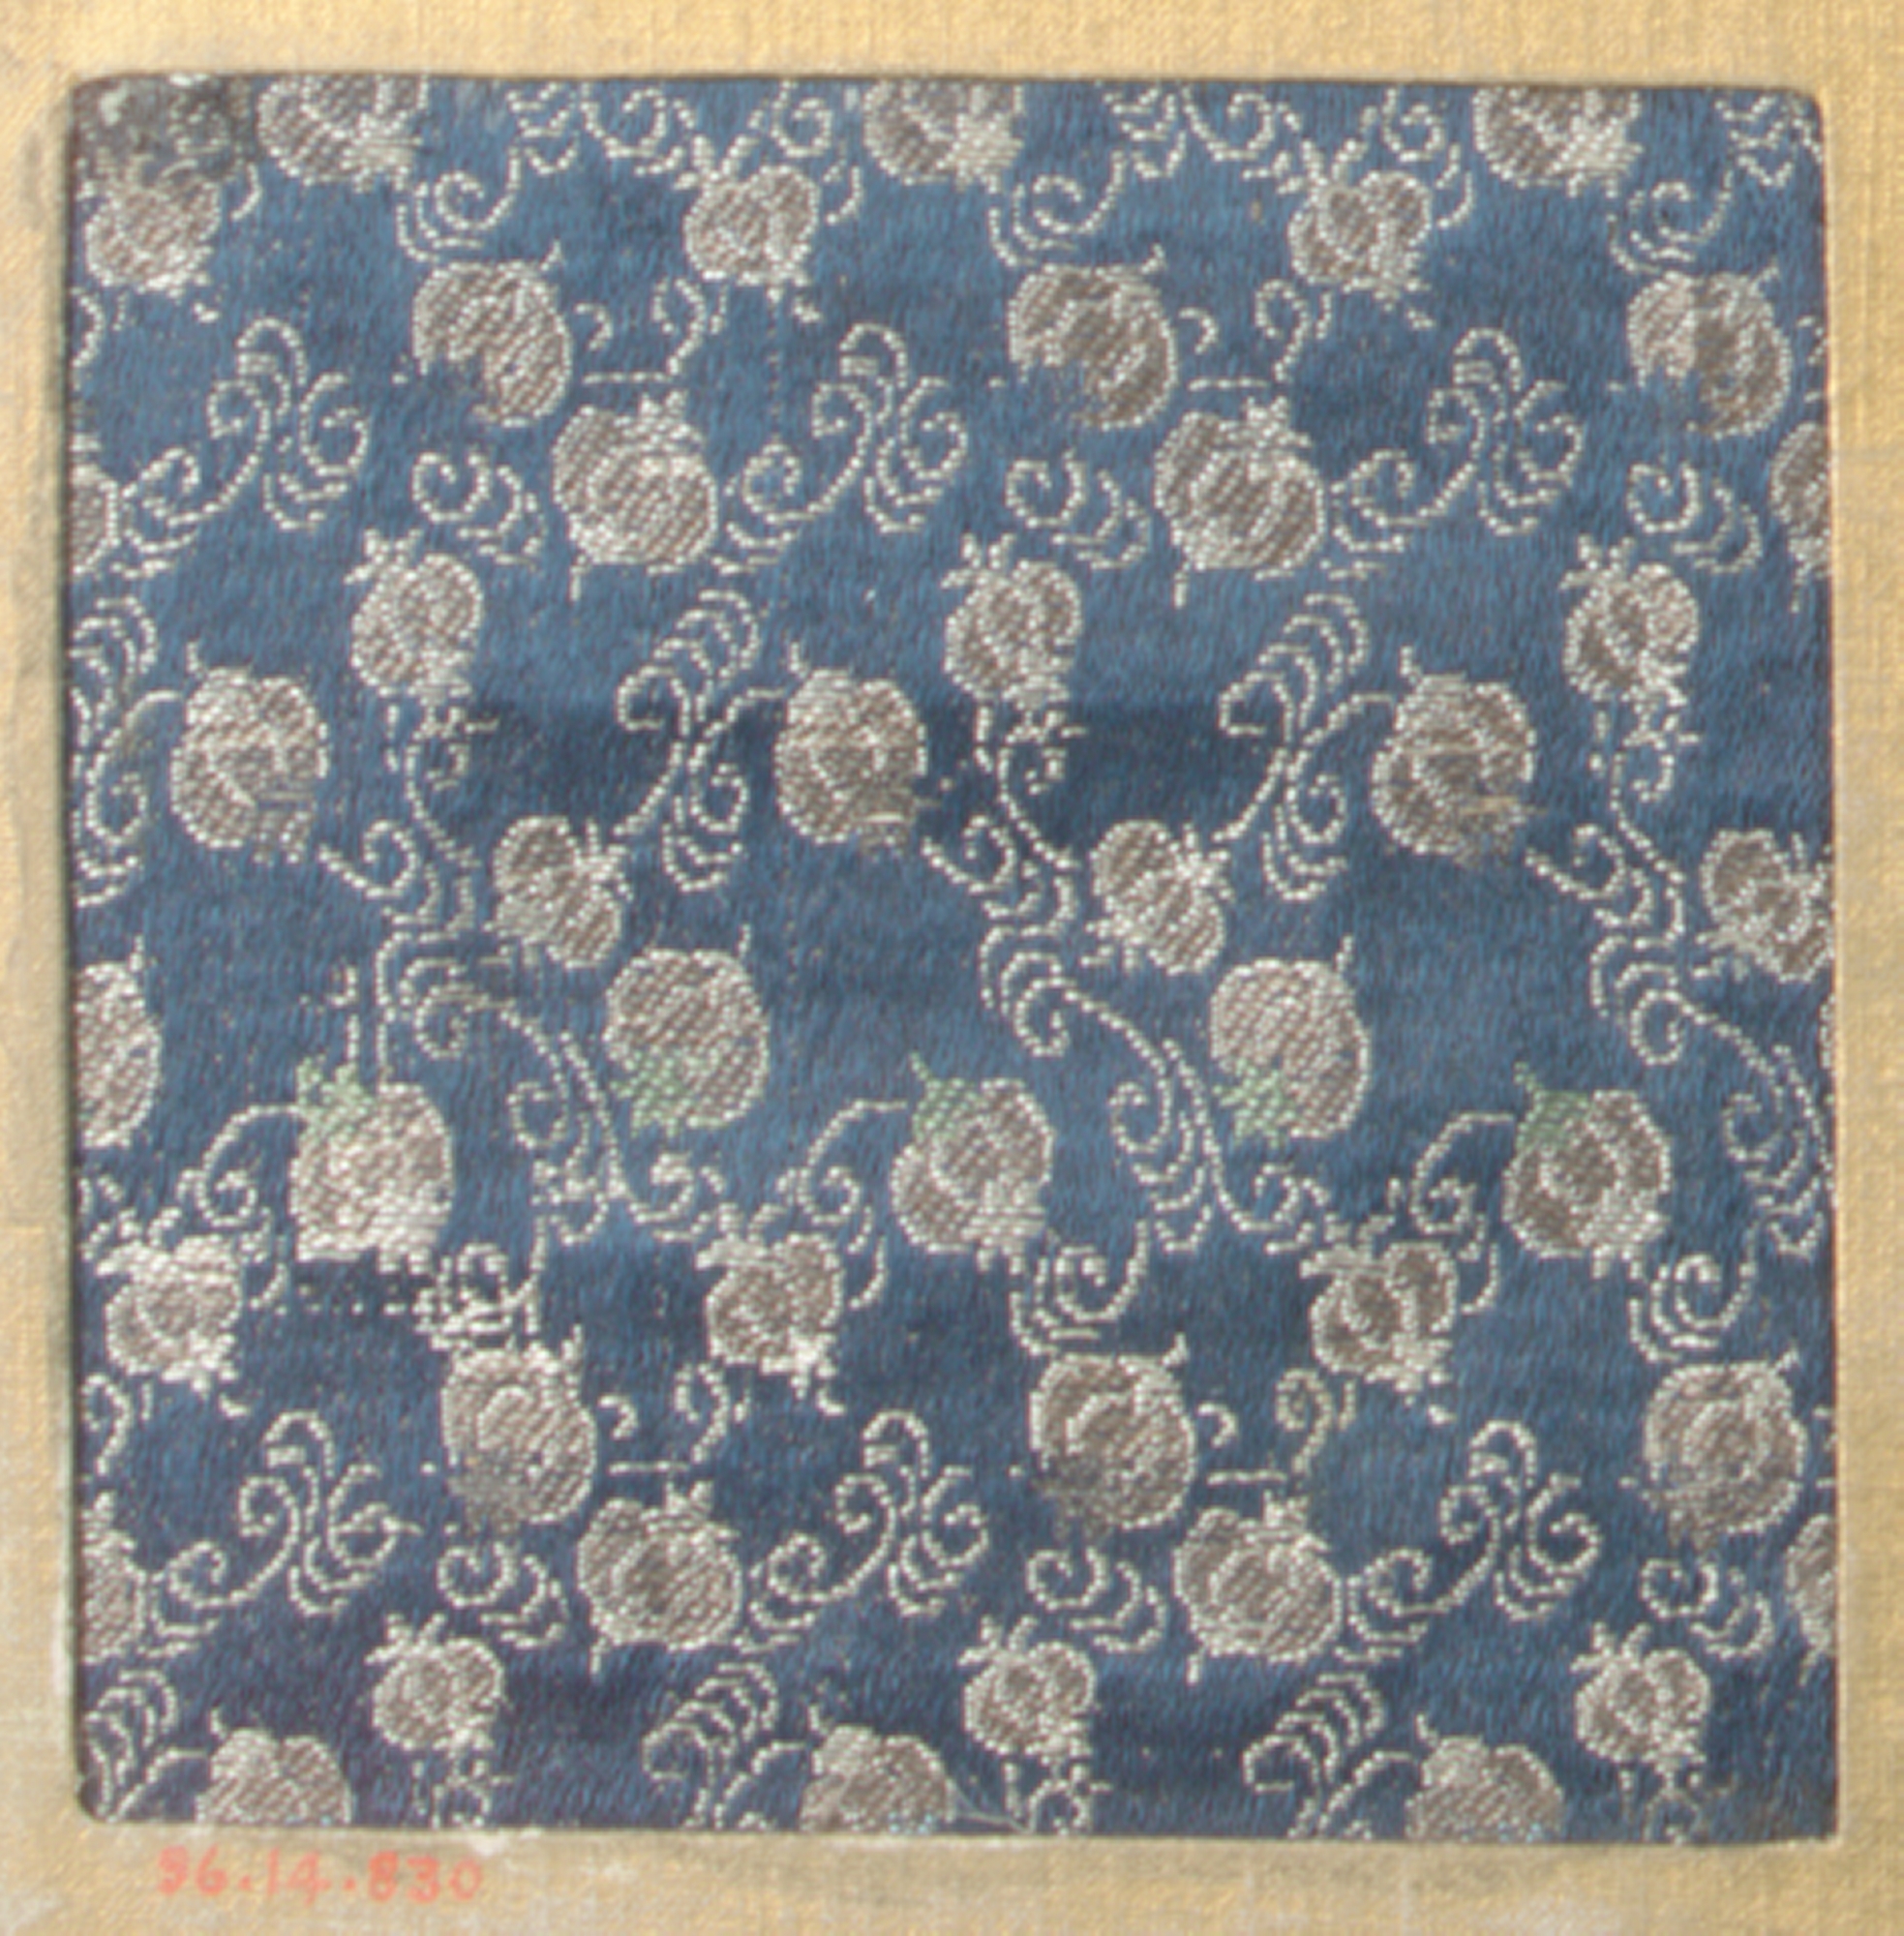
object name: piece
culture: japanese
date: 1701-1900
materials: silk